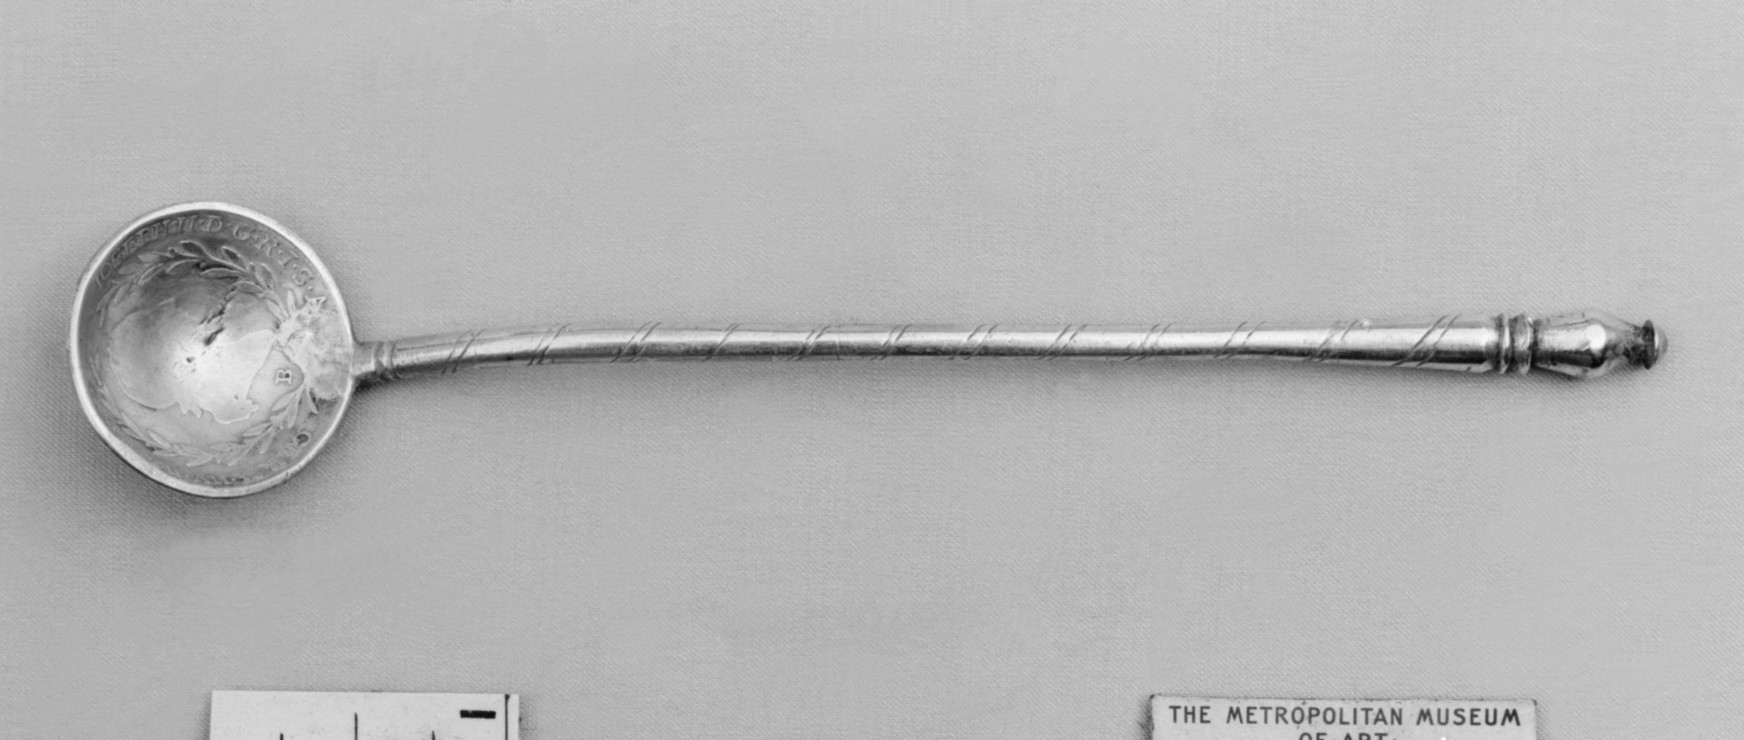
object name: spoon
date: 1767-1833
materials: silver